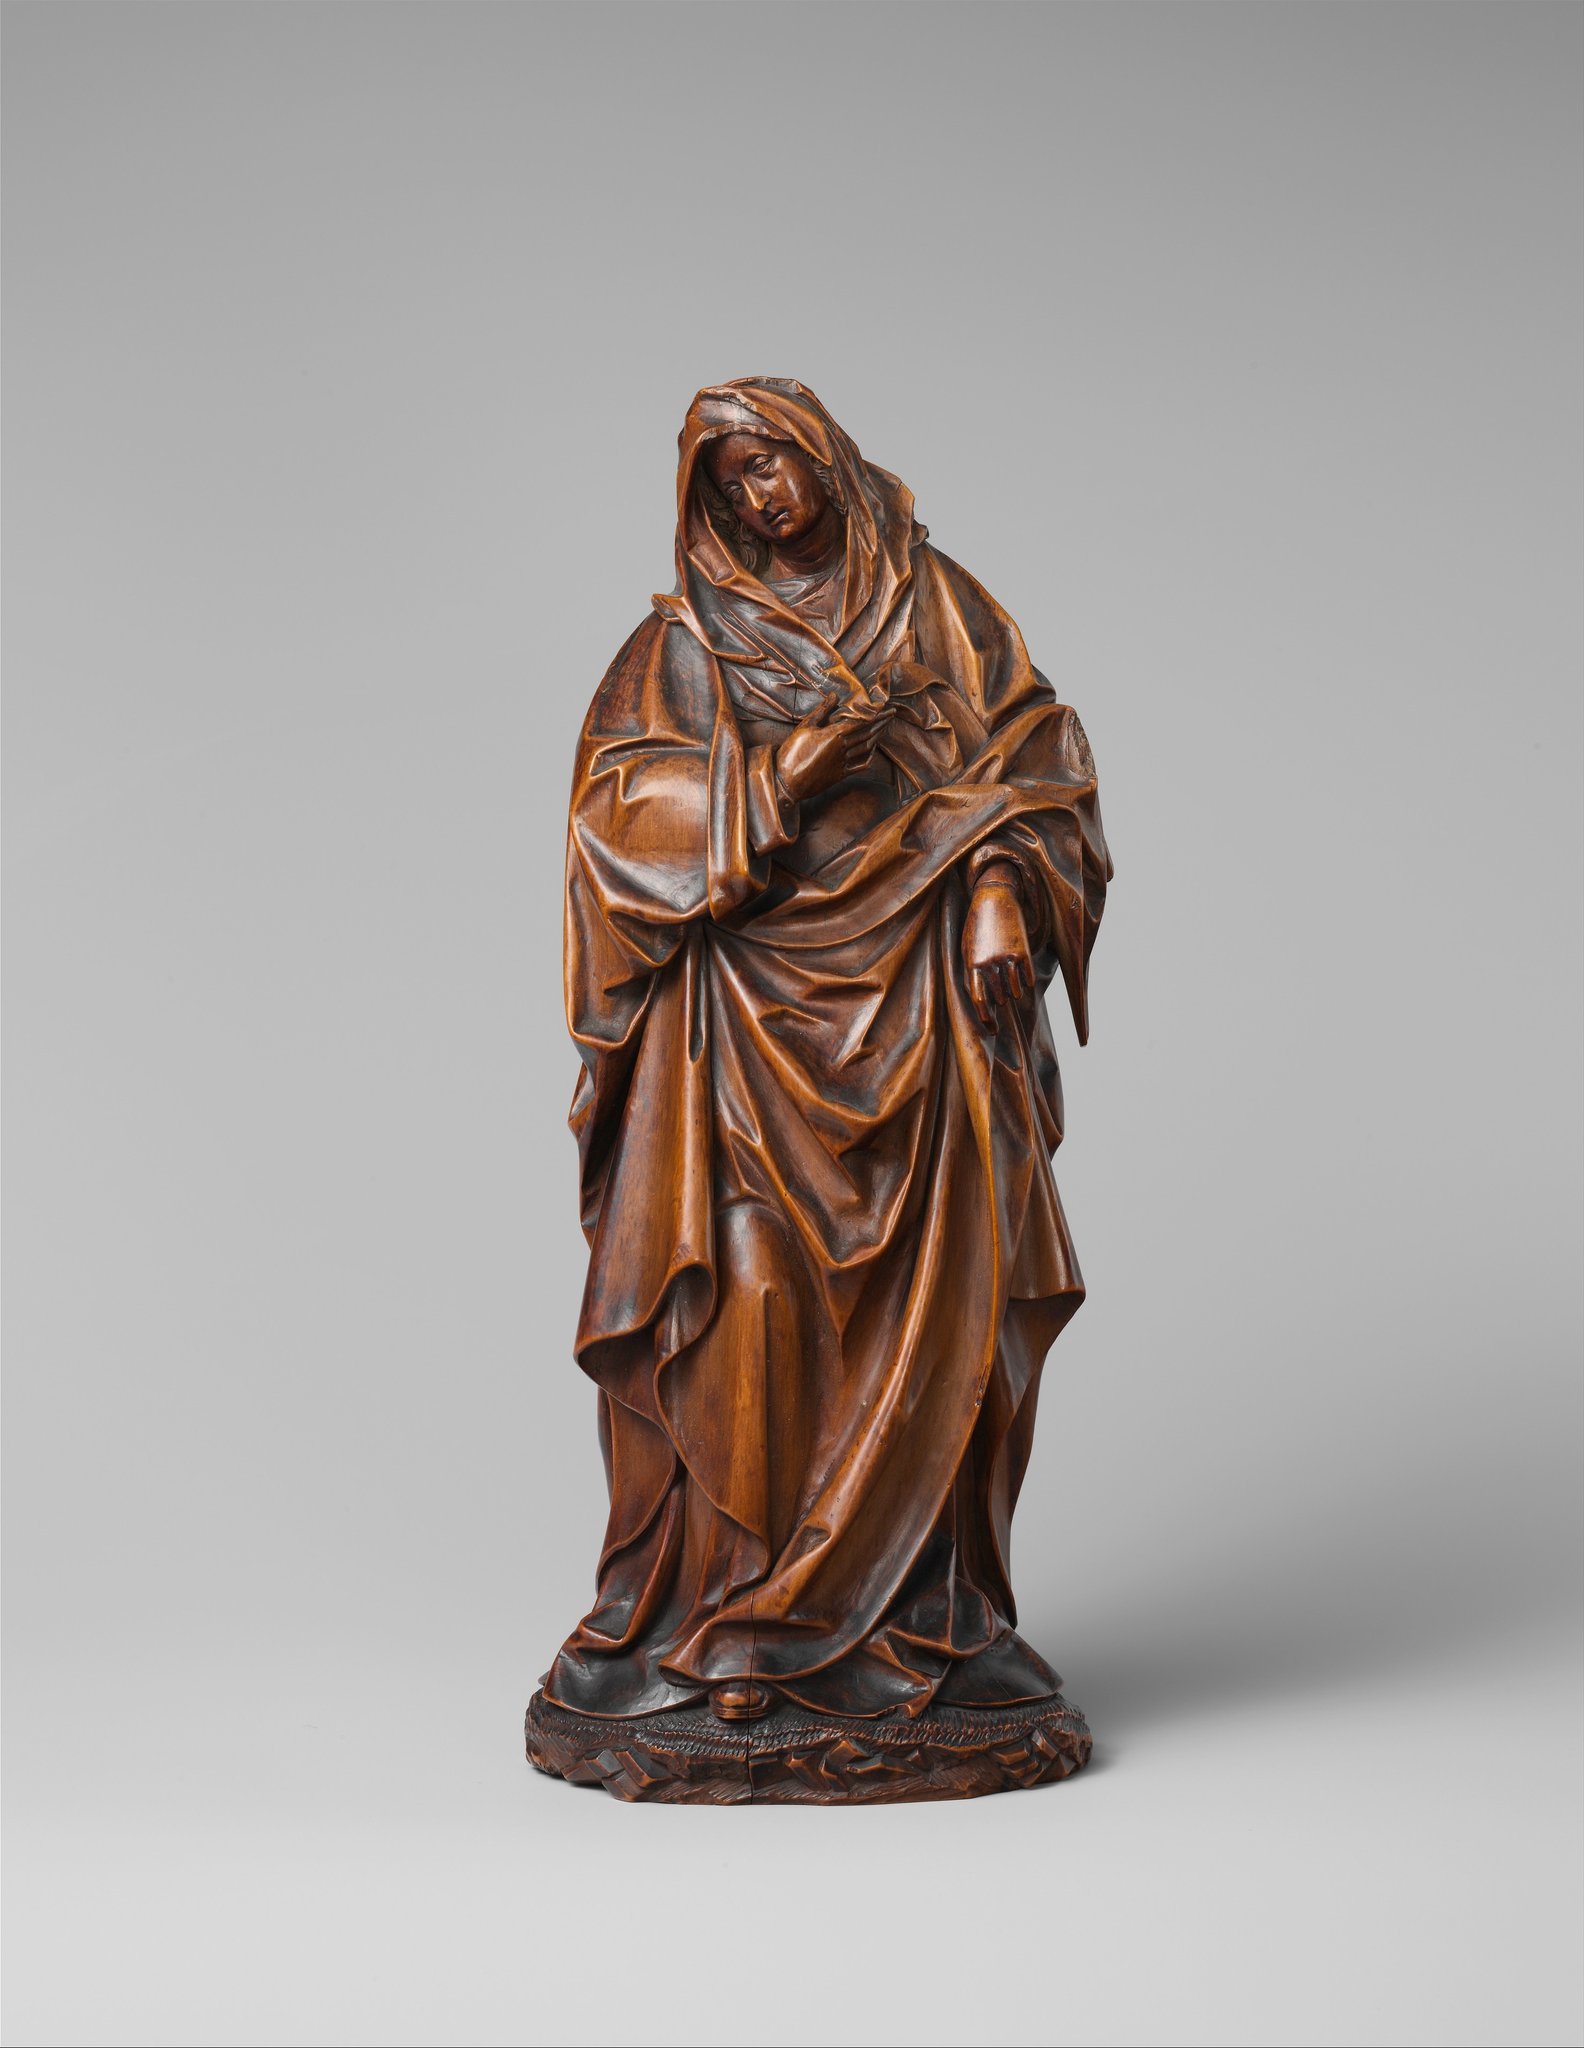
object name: statuette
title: The Virgin Mary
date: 1560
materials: wood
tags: virgin mary